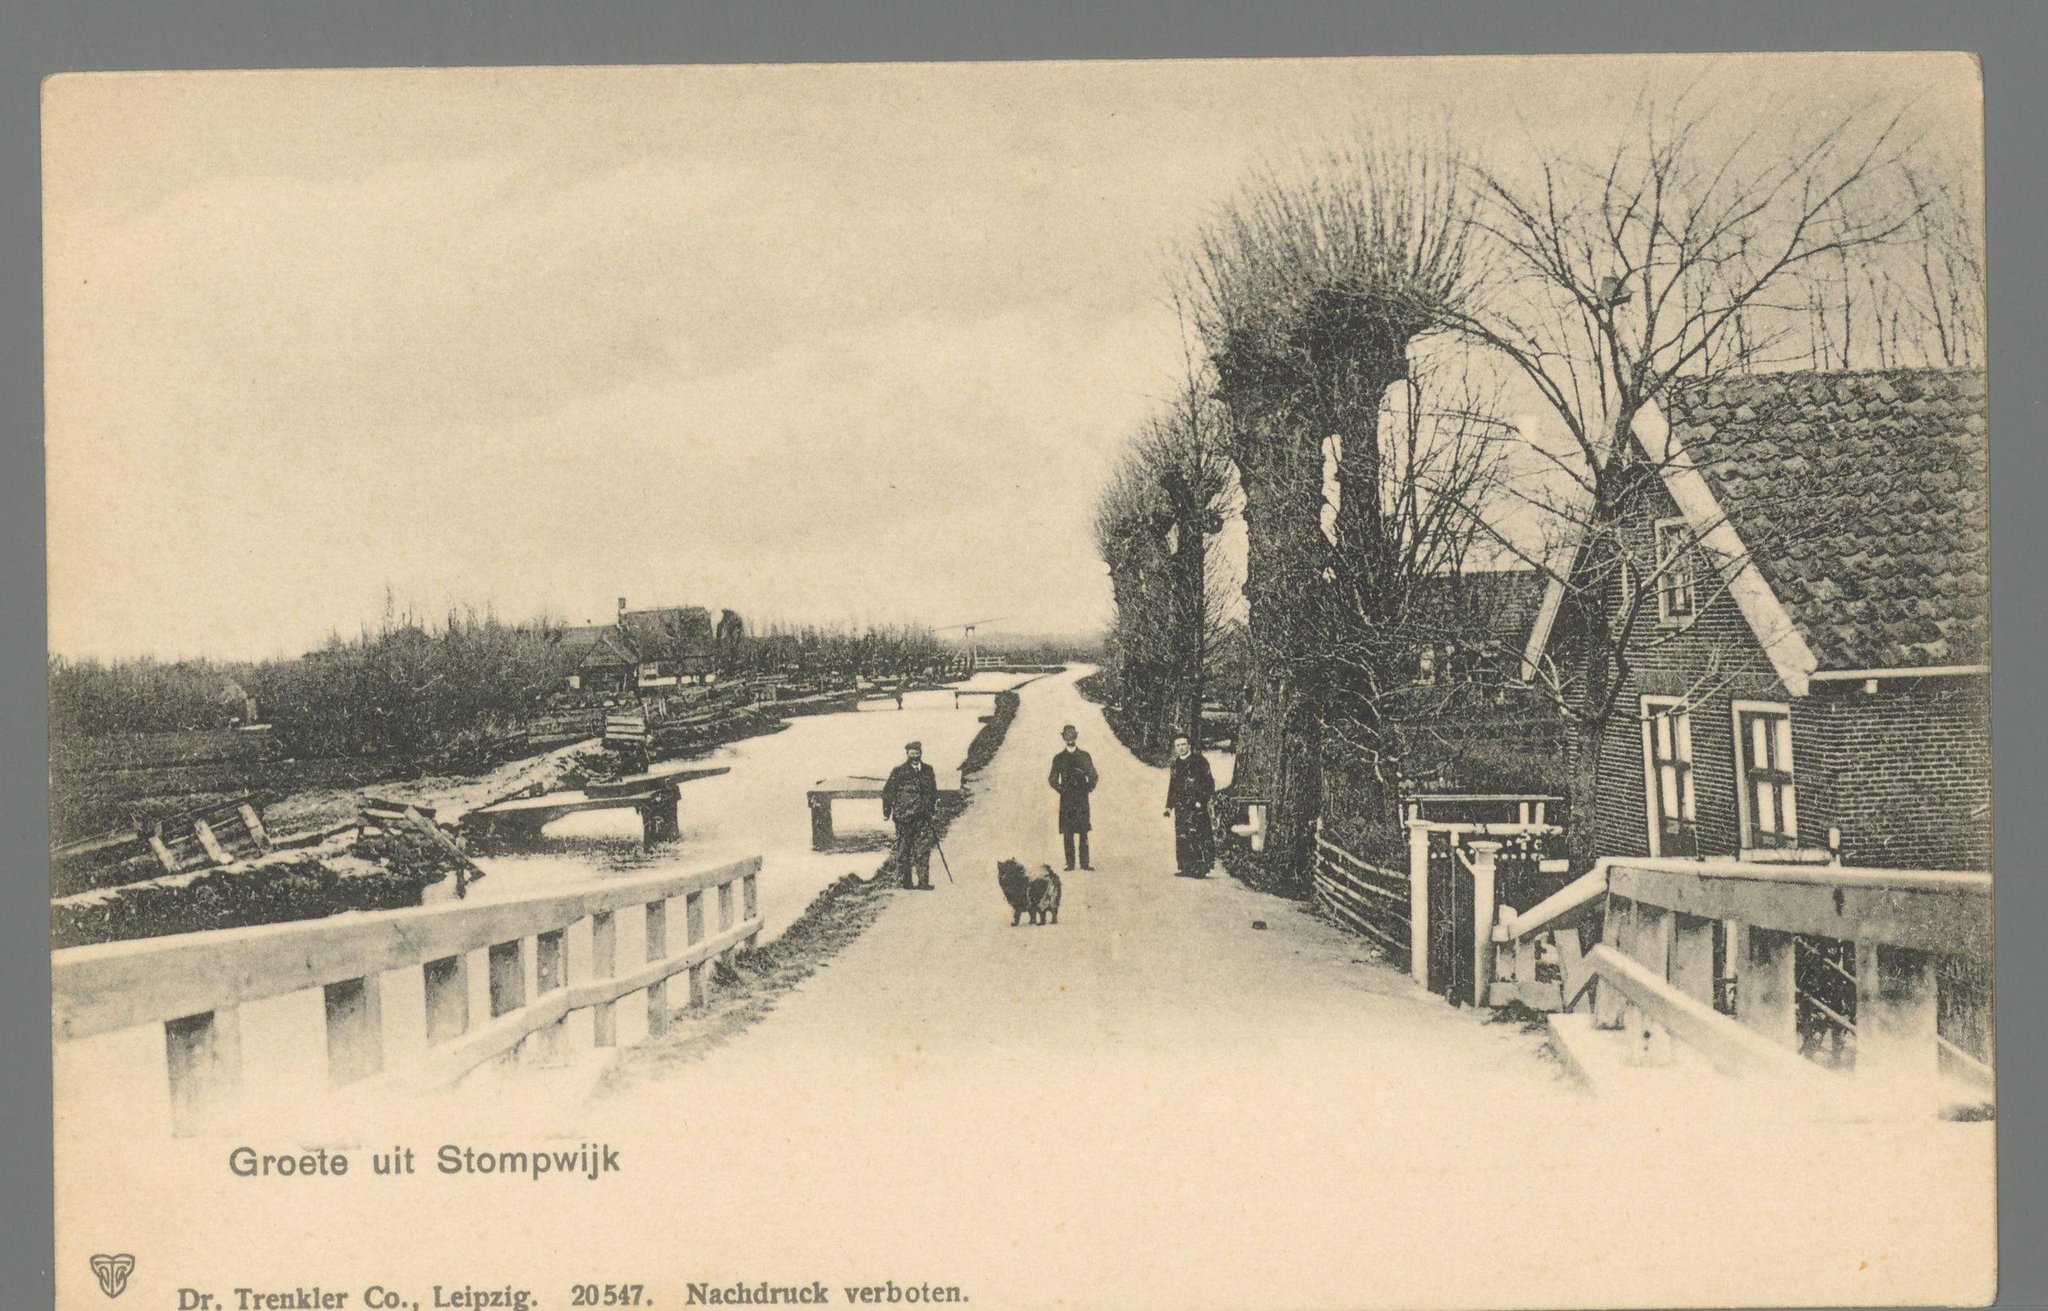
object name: ansichtkaart, prentbriefkaart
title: Groete uit Stompwijk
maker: Anonymous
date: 1897-1905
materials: cardboard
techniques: photograph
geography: stompwijk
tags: city-view, and landscape with man-made constructions, canals, waters (in village), street